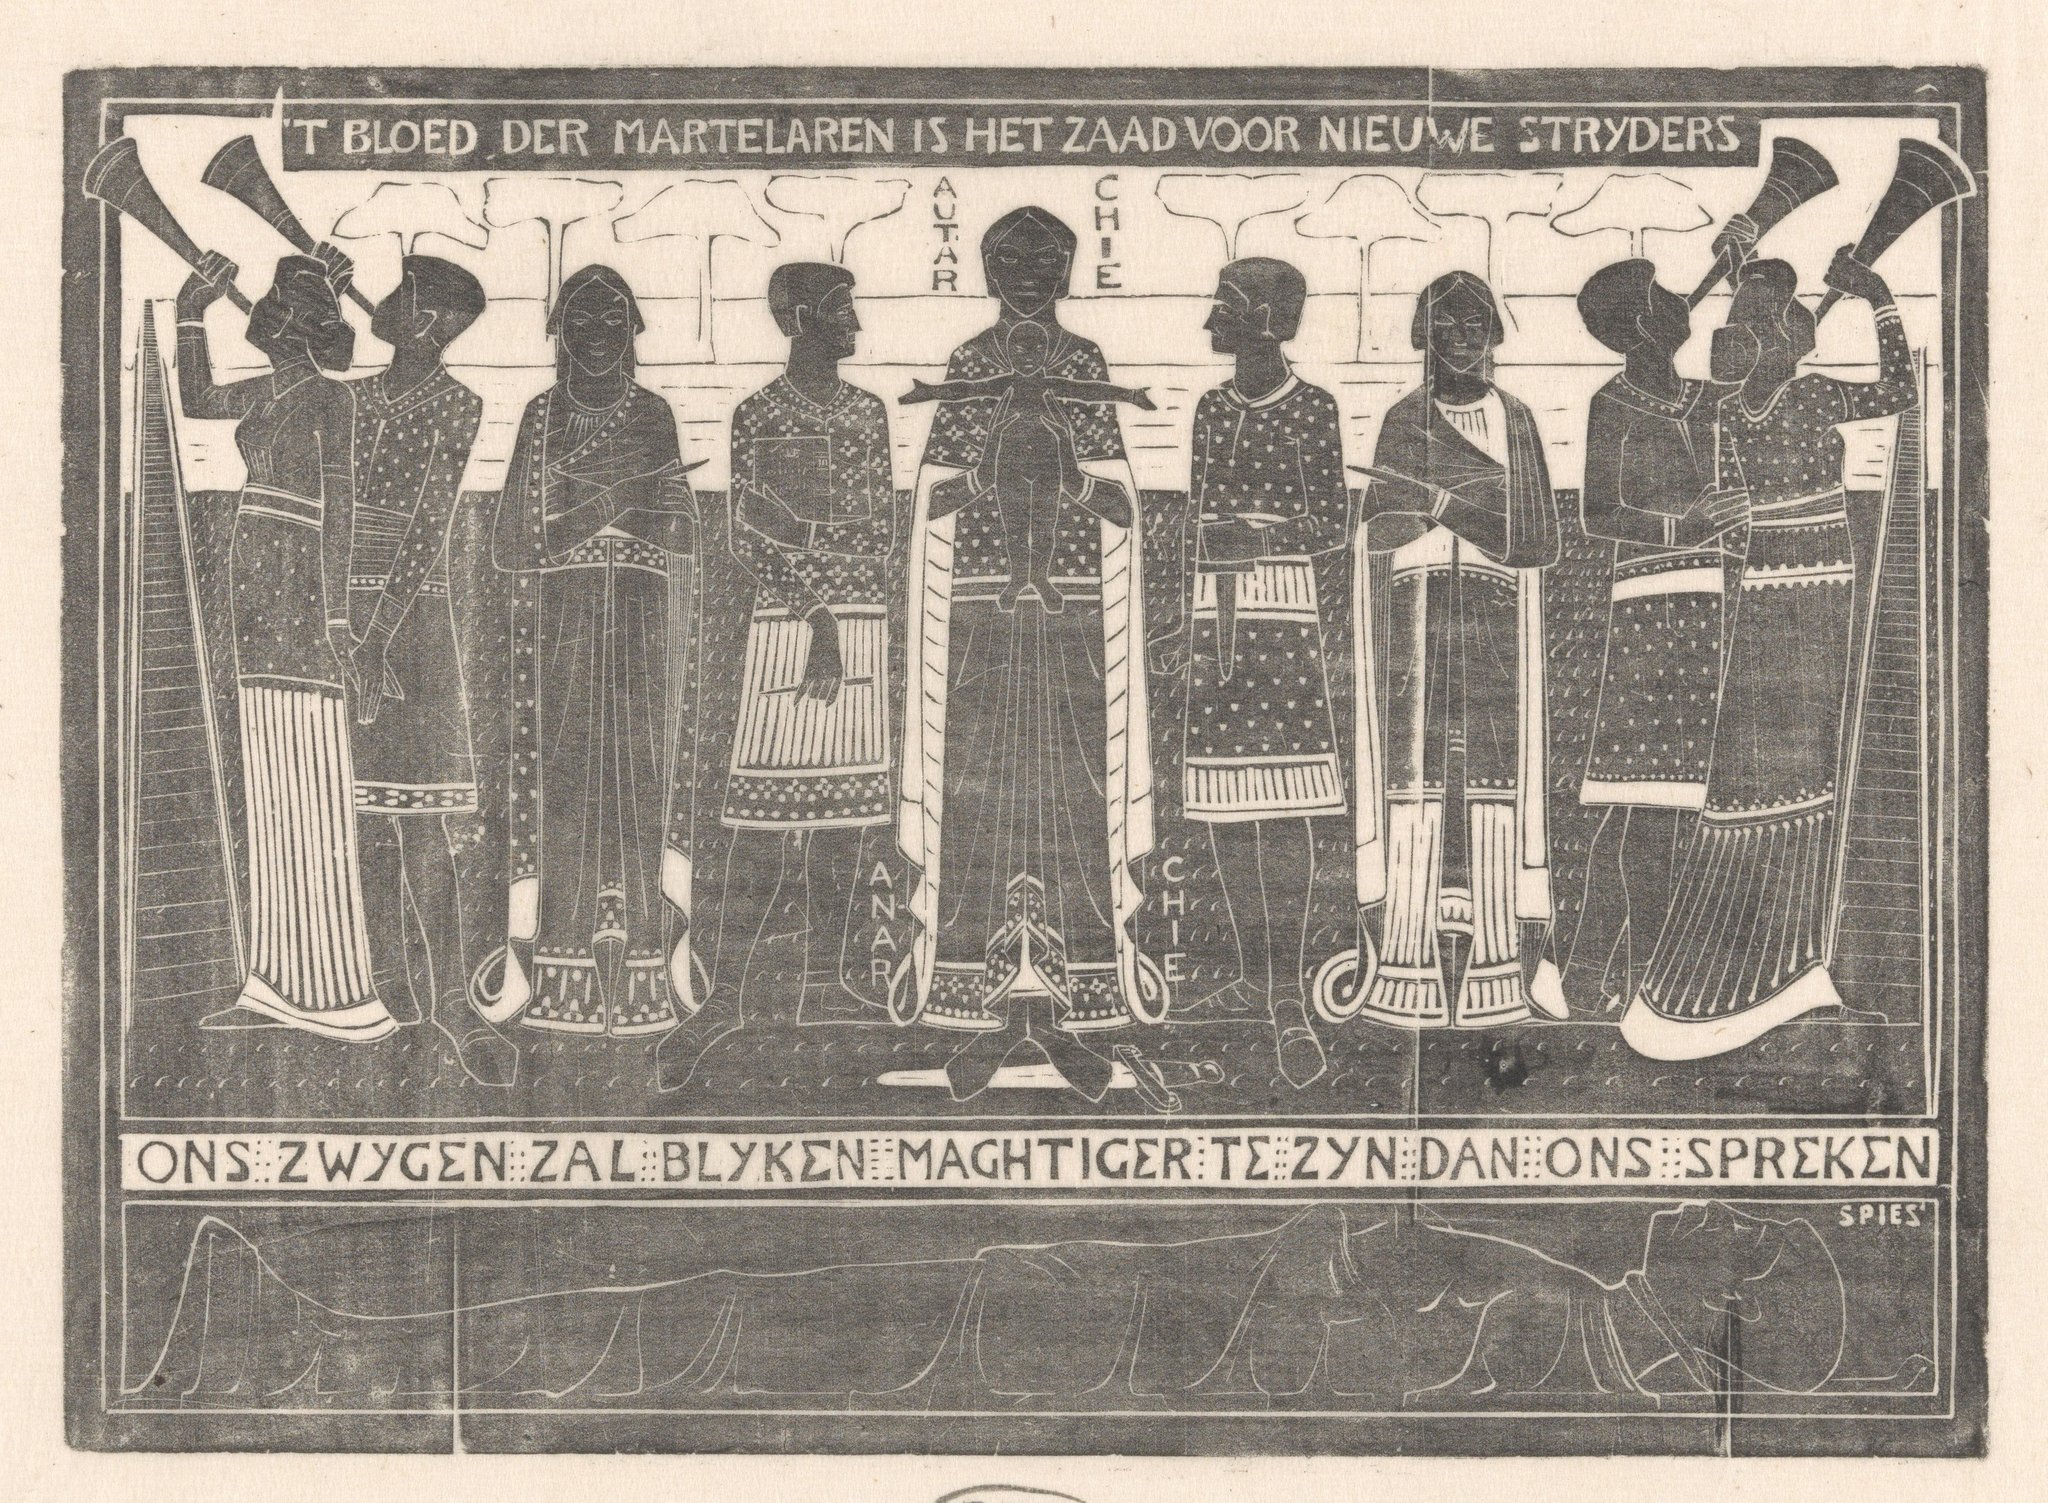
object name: print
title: Herdenkingsprent voor de Haymarket-affaire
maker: karel petrus cornelis de bazel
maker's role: draughtsman, print maker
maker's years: 1869-1923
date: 1894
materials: paper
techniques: woodcut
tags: injustice; 'ingiustitia' (ripa), working class, labourers, infant, baby ~ the ages of man, the corpse, strike (political demonstration)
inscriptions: collector's mark: Lugt 2228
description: Een herdenkingsprent voor de personen die tijdens de Haymarket-affaire ten onrechte verantwoordelijk werden gesteld voor het plegen van een bomaanslag op 4 mei 1886 tijdens een arbeidersdemonstratie in Chicago. In het midden op de prent een symmetrisch opgestelde groep van tien figuren, waarvan de buitenste vier een blaasinstrument aan de mond hebben gezet. De middelste figuur houdt een naakt kind voor zich dat de armen gespreid houdt. Naast het lichaam van de middelste figuur de woorden 'autarchie' en 'anarchie'. Boven de groep figuren de tekst ''t Bloed der martelaren is het zaad voor nieuwe strijders'. Onder de groep figuren de tekst 'Ons zwijgen zal blijken machtiger te zijn dan ons spreken', de laatste woorden van August Spies, één van de onrechtmatig veroordeelden. Helemaal onderaan zijn opgebaarde lichaam.